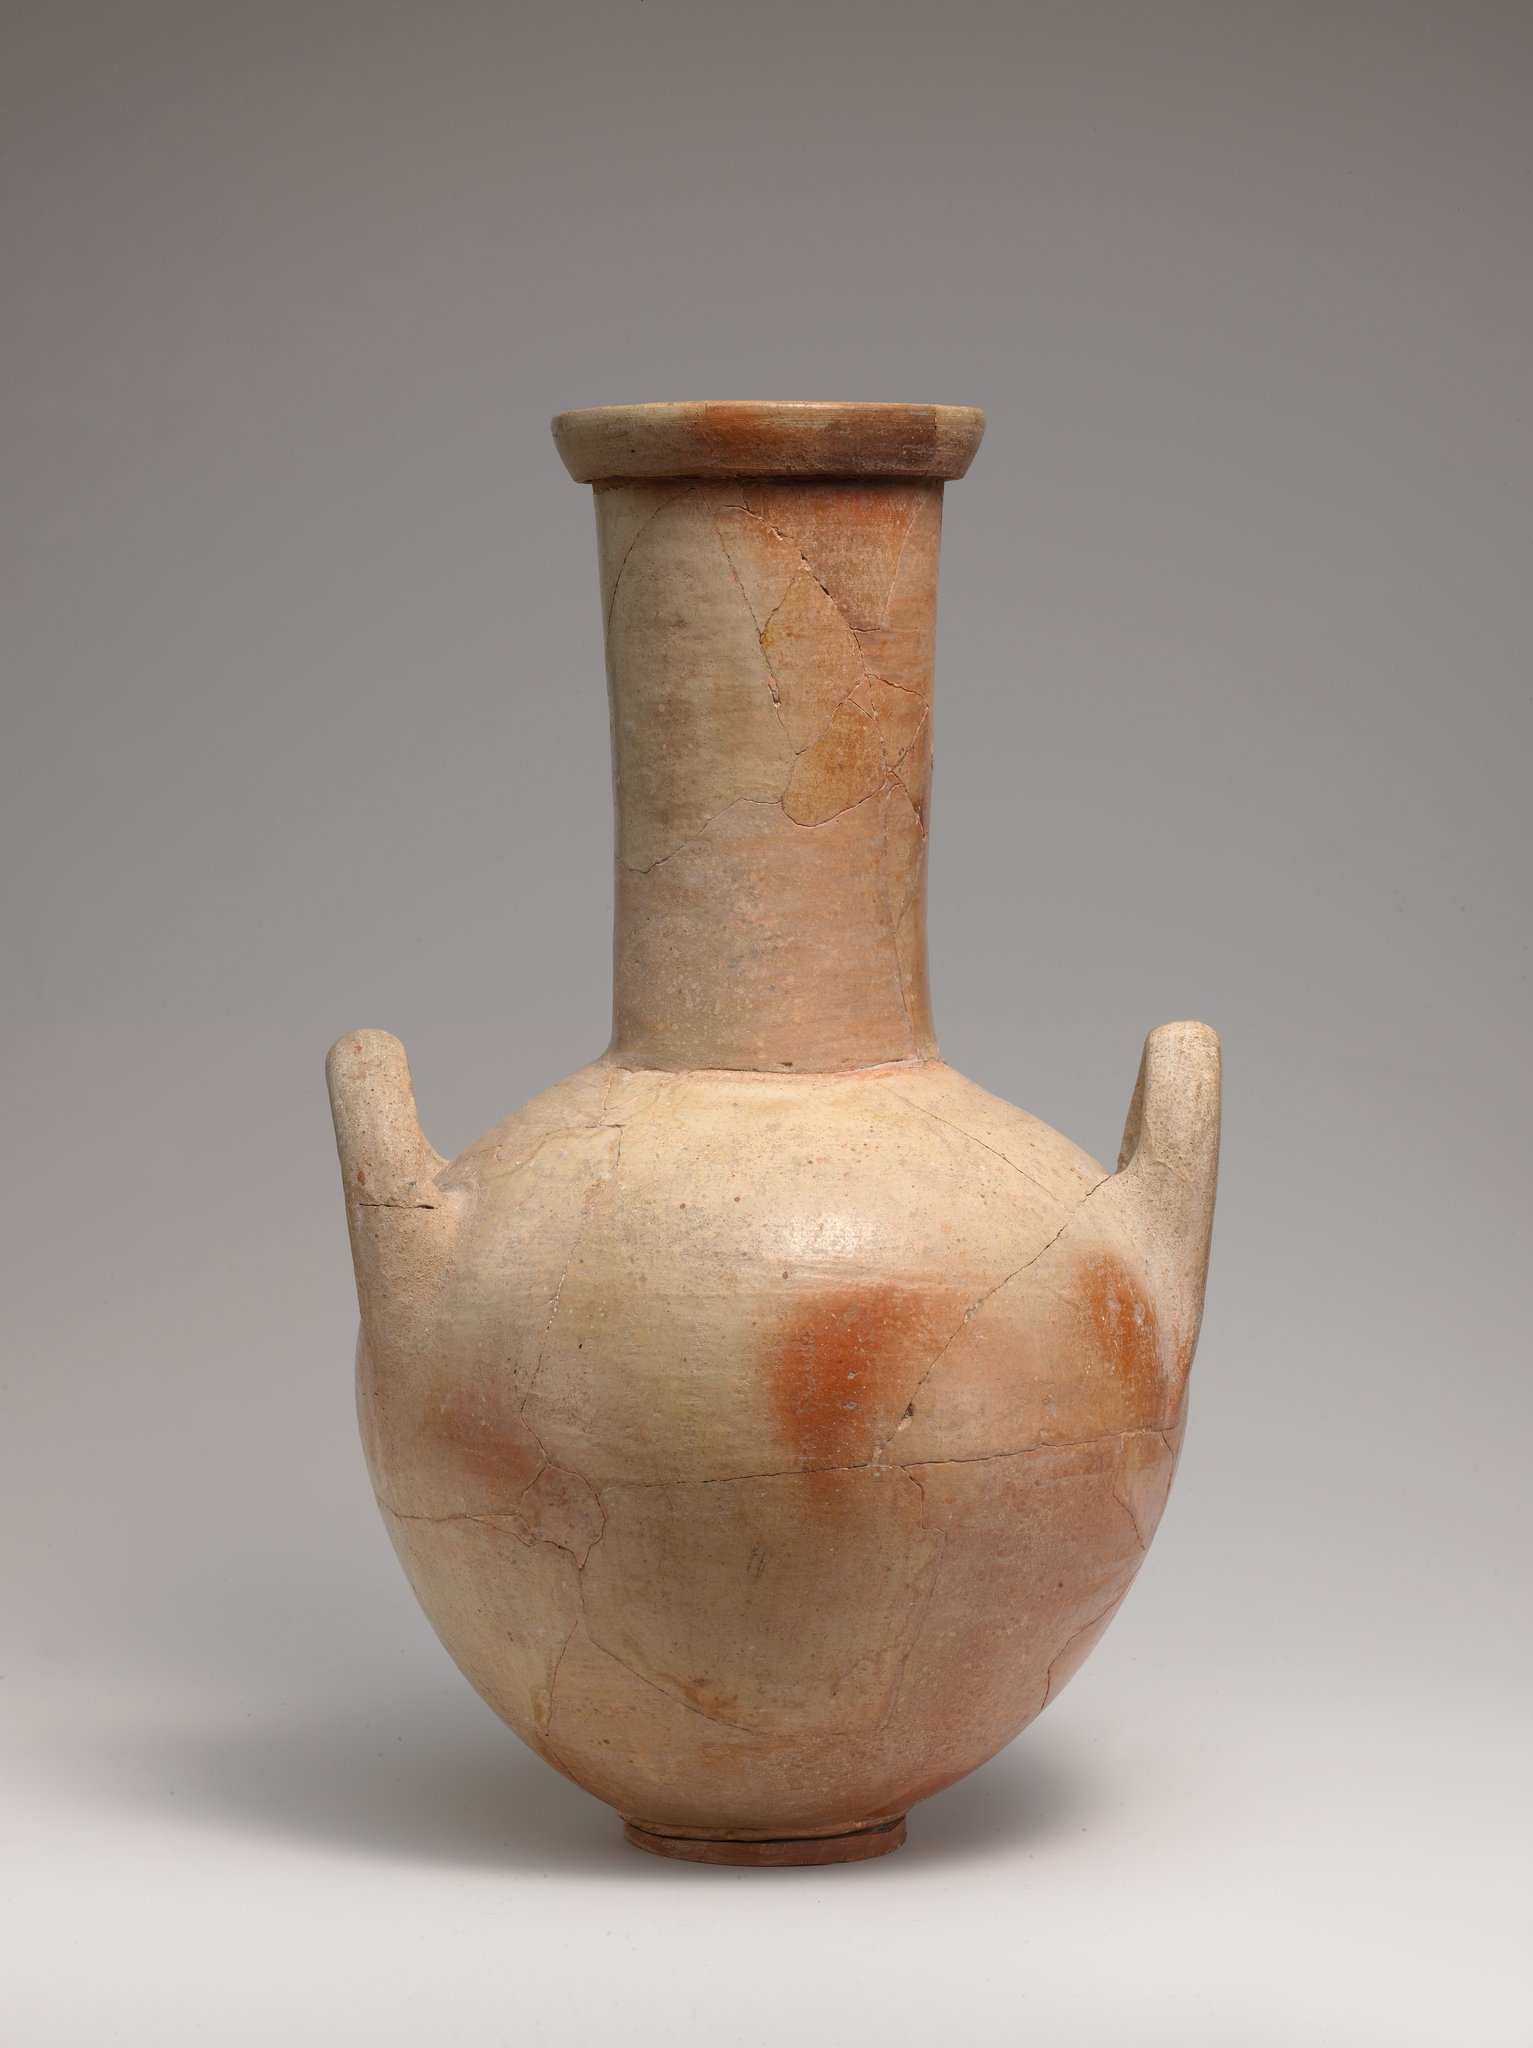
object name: amphora, two handled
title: Two-Handled Jar from Tutankhamun's Embalming Cache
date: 1336-1327 BCE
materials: pottery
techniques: burnishing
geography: egypt